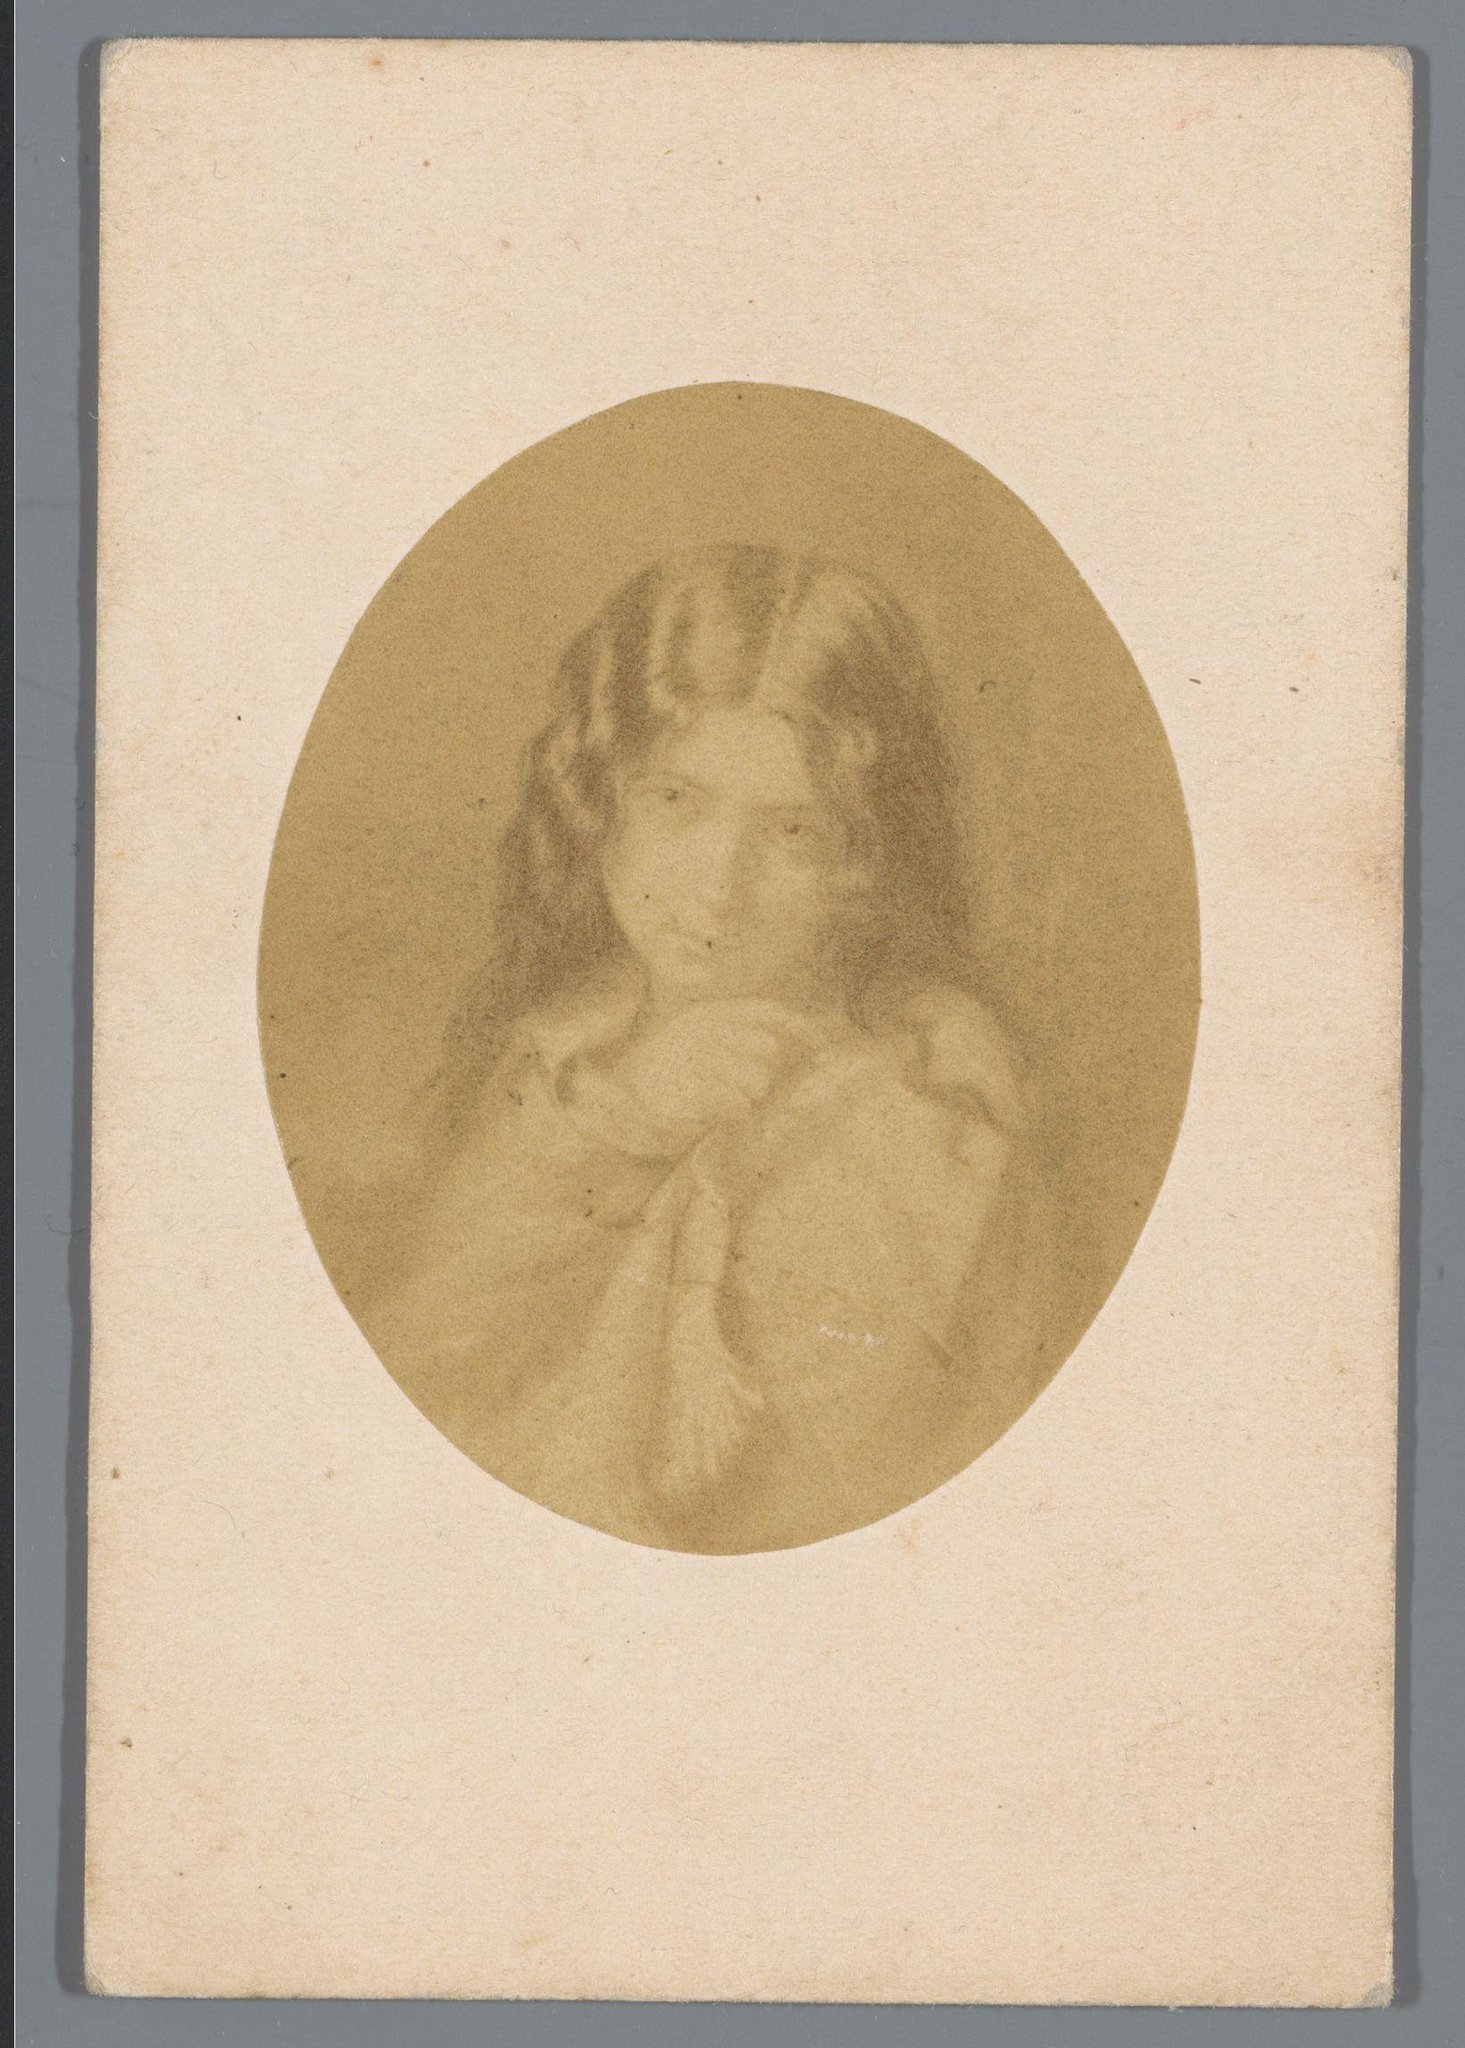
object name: photograph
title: Fotoreproductie van een schilderij naar het gedicht Ga ter ruste! door J.J.L. ten Kate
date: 1850-1900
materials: cardboard, photographic support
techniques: albumen print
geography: amsterdam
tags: historical persons not known by name - bb - woman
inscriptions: inscription: ‘GA TER RUSTE!/ (...) J. J. L. TEN KATE./ (Vrij naar 't Hoogd v. CARL BECK.)’